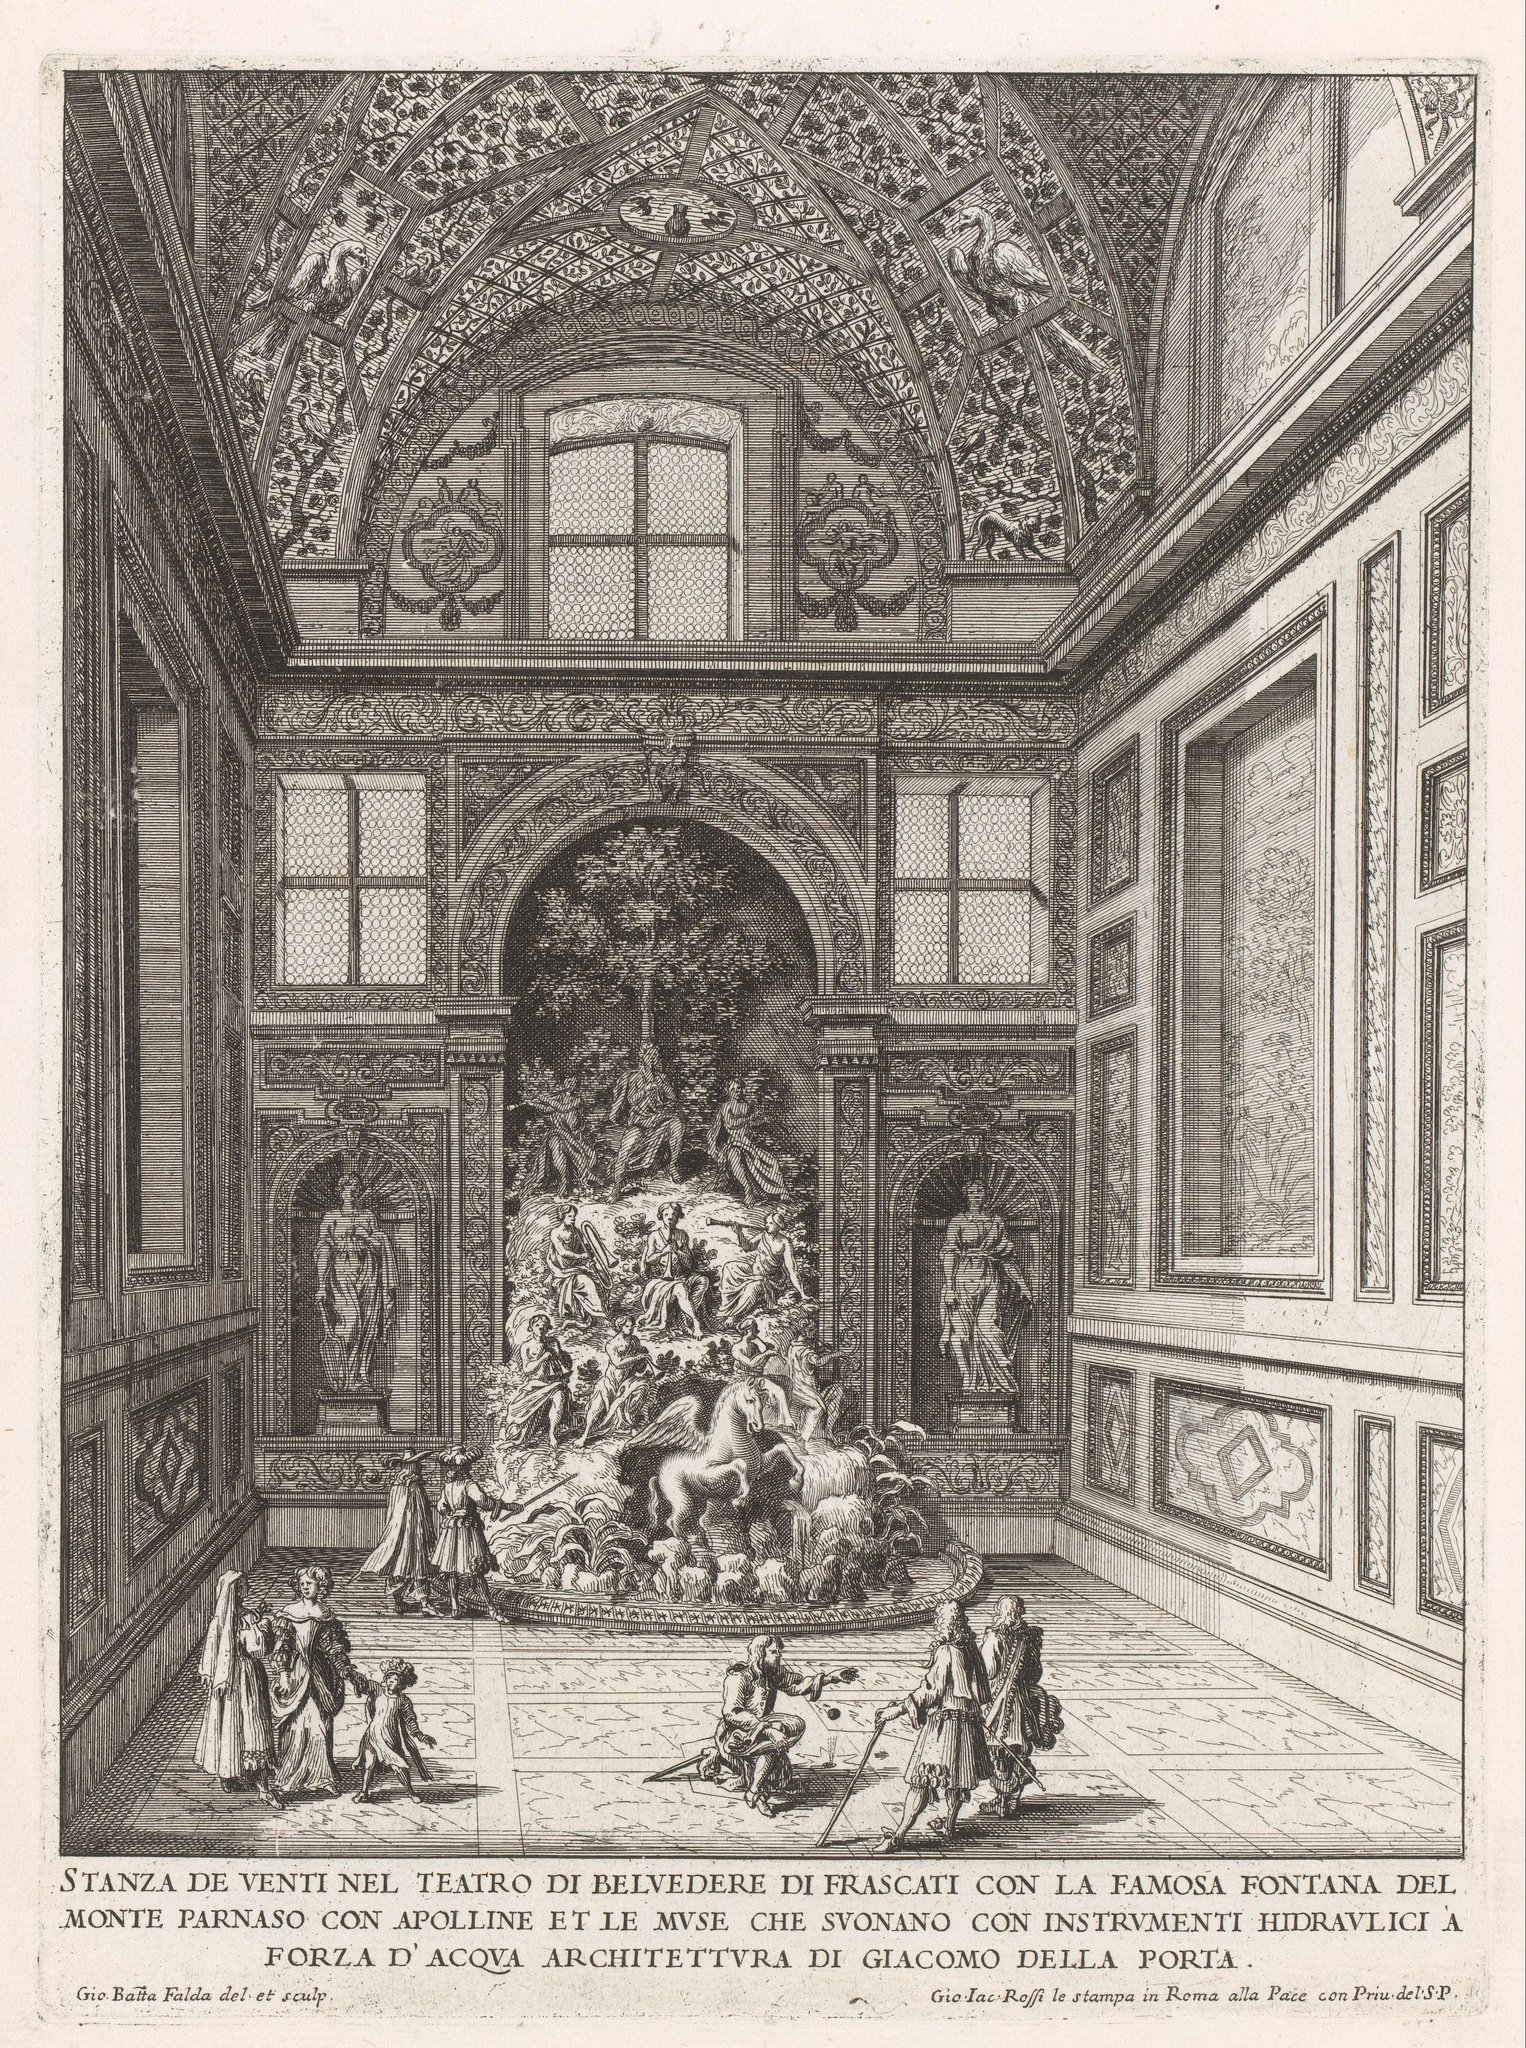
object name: print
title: Stanza dei Venti in de tuinen van de Villa Aldobrandini te Frascati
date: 1653-1691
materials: paper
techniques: etching, intaglio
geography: italy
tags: fluid mechanics, hydraulics, parnassus, sacred to apollo musagetes, wind instruments, ornamental fountain